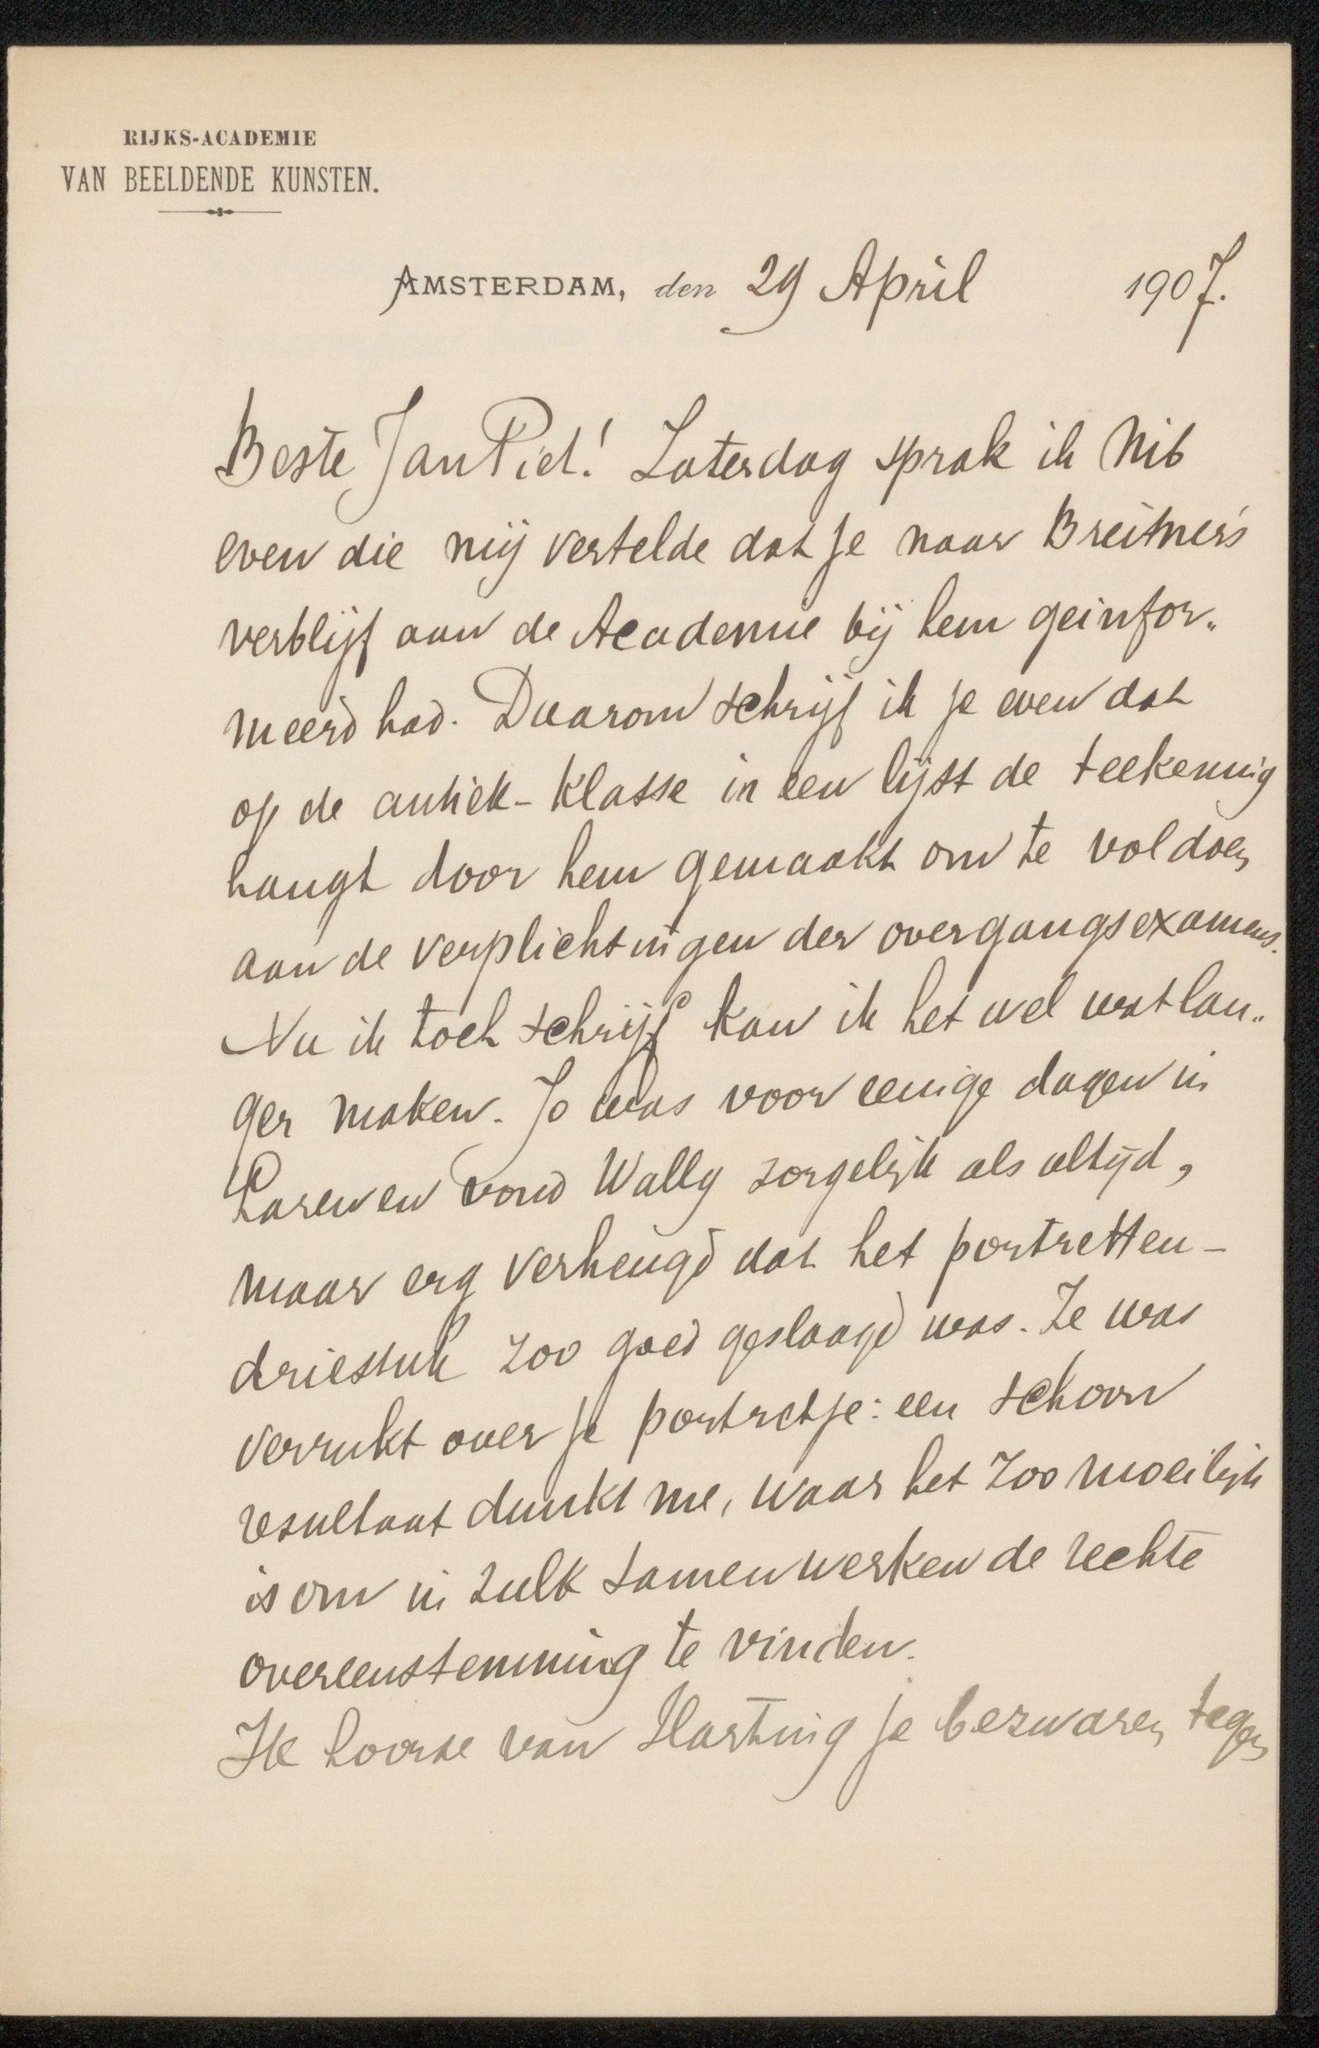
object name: letter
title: Brief aan Jan Veth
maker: antoon derkinderen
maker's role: draughtsman, painter, print maker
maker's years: 1859-1925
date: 1907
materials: ink, paper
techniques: pen, printing, writing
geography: amsterdam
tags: rotterdam, george hendrik breitner, designer, jan veth, amsterdam, print maker, draughtsman, wally moes, haarlem, painter, dirk harting, drawing, anonymous historical person portrayed, money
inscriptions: collector's mark: ‘RPK’